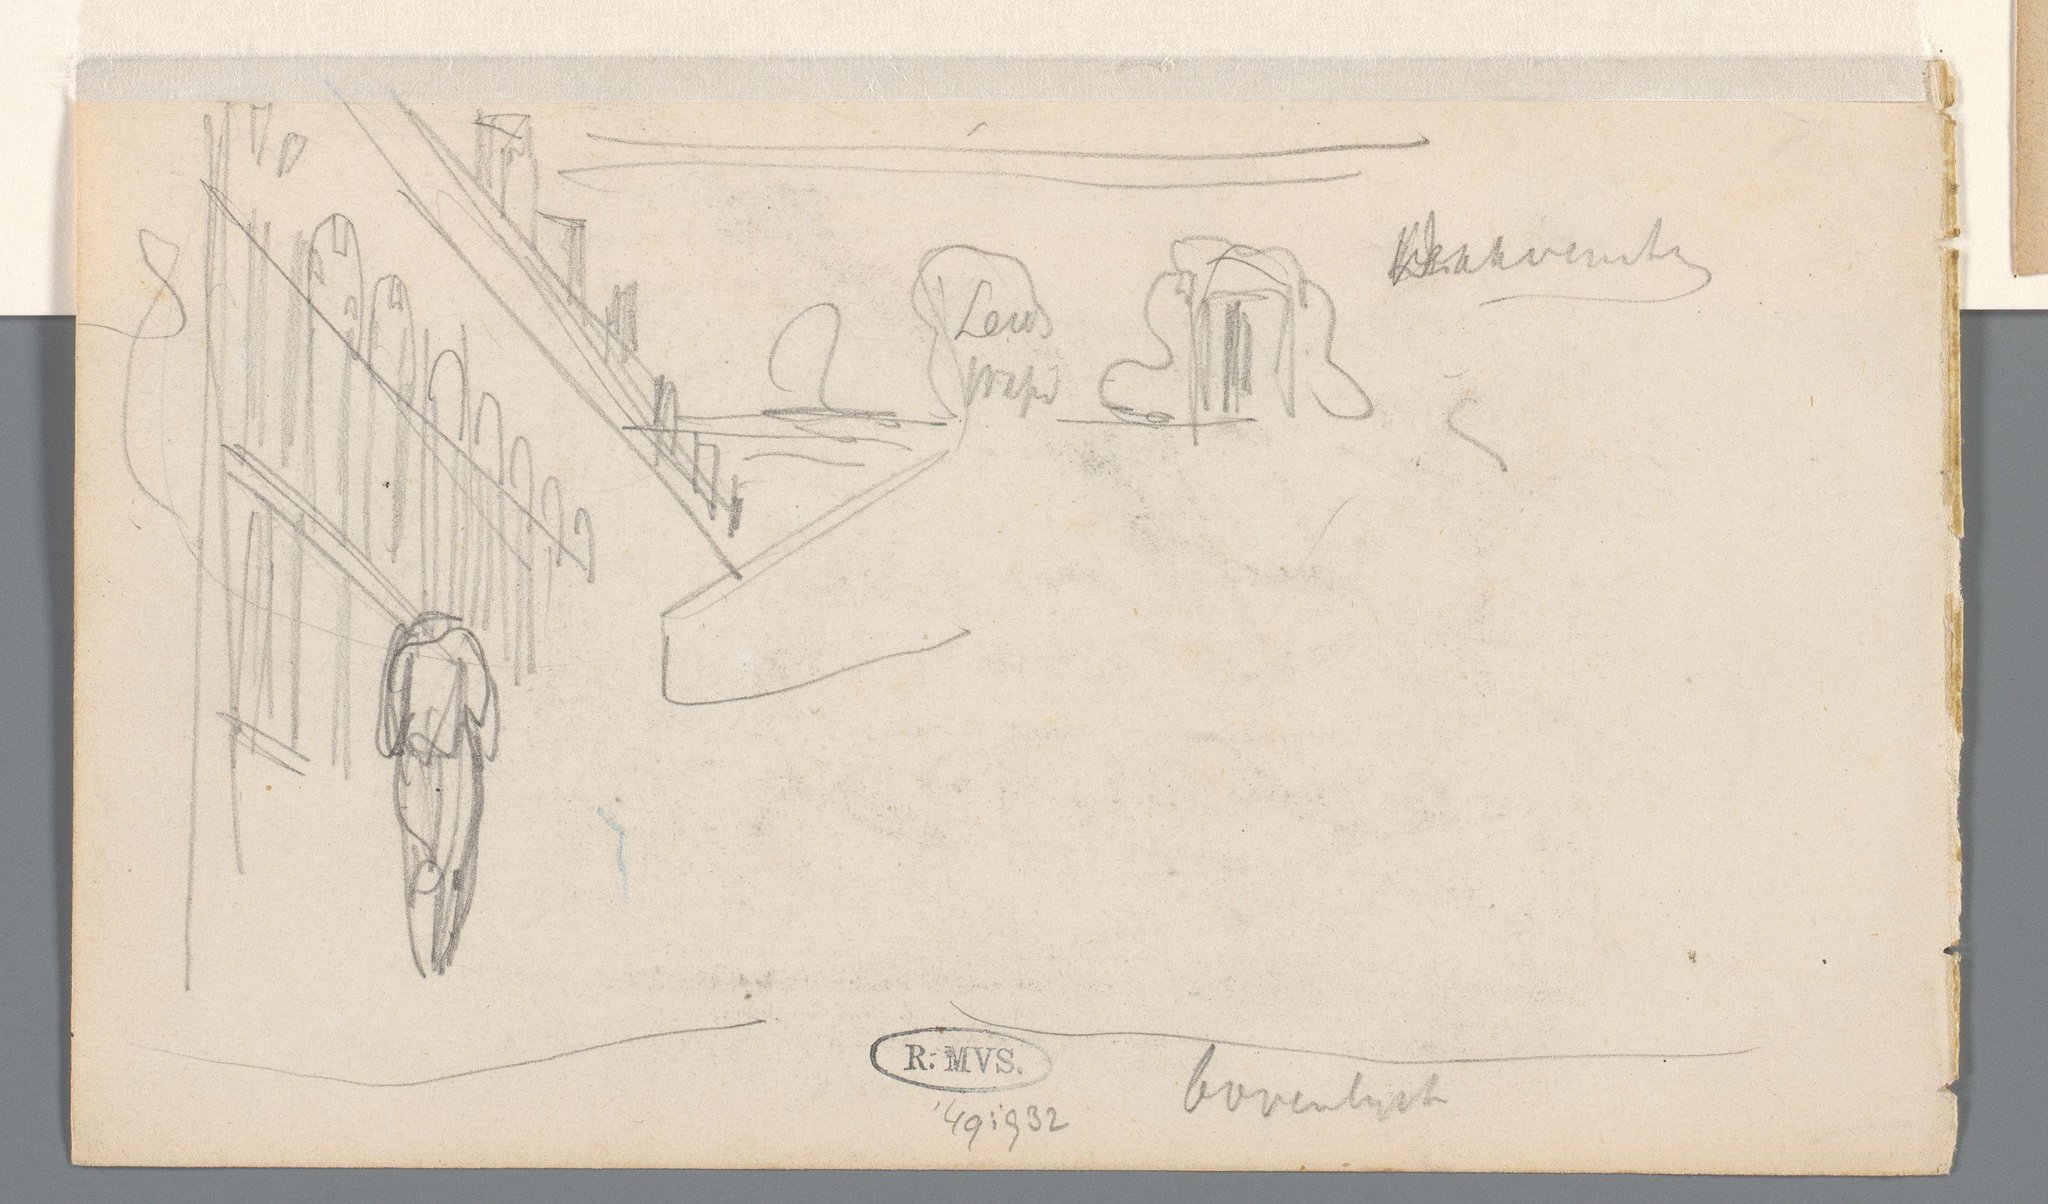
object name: drawing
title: Schetsblad met architectuurstudies, gevel van een woonblok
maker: august allebé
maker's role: draughtsman, print maker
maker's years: 1838-1927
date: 1848-1927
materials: paper, pencil